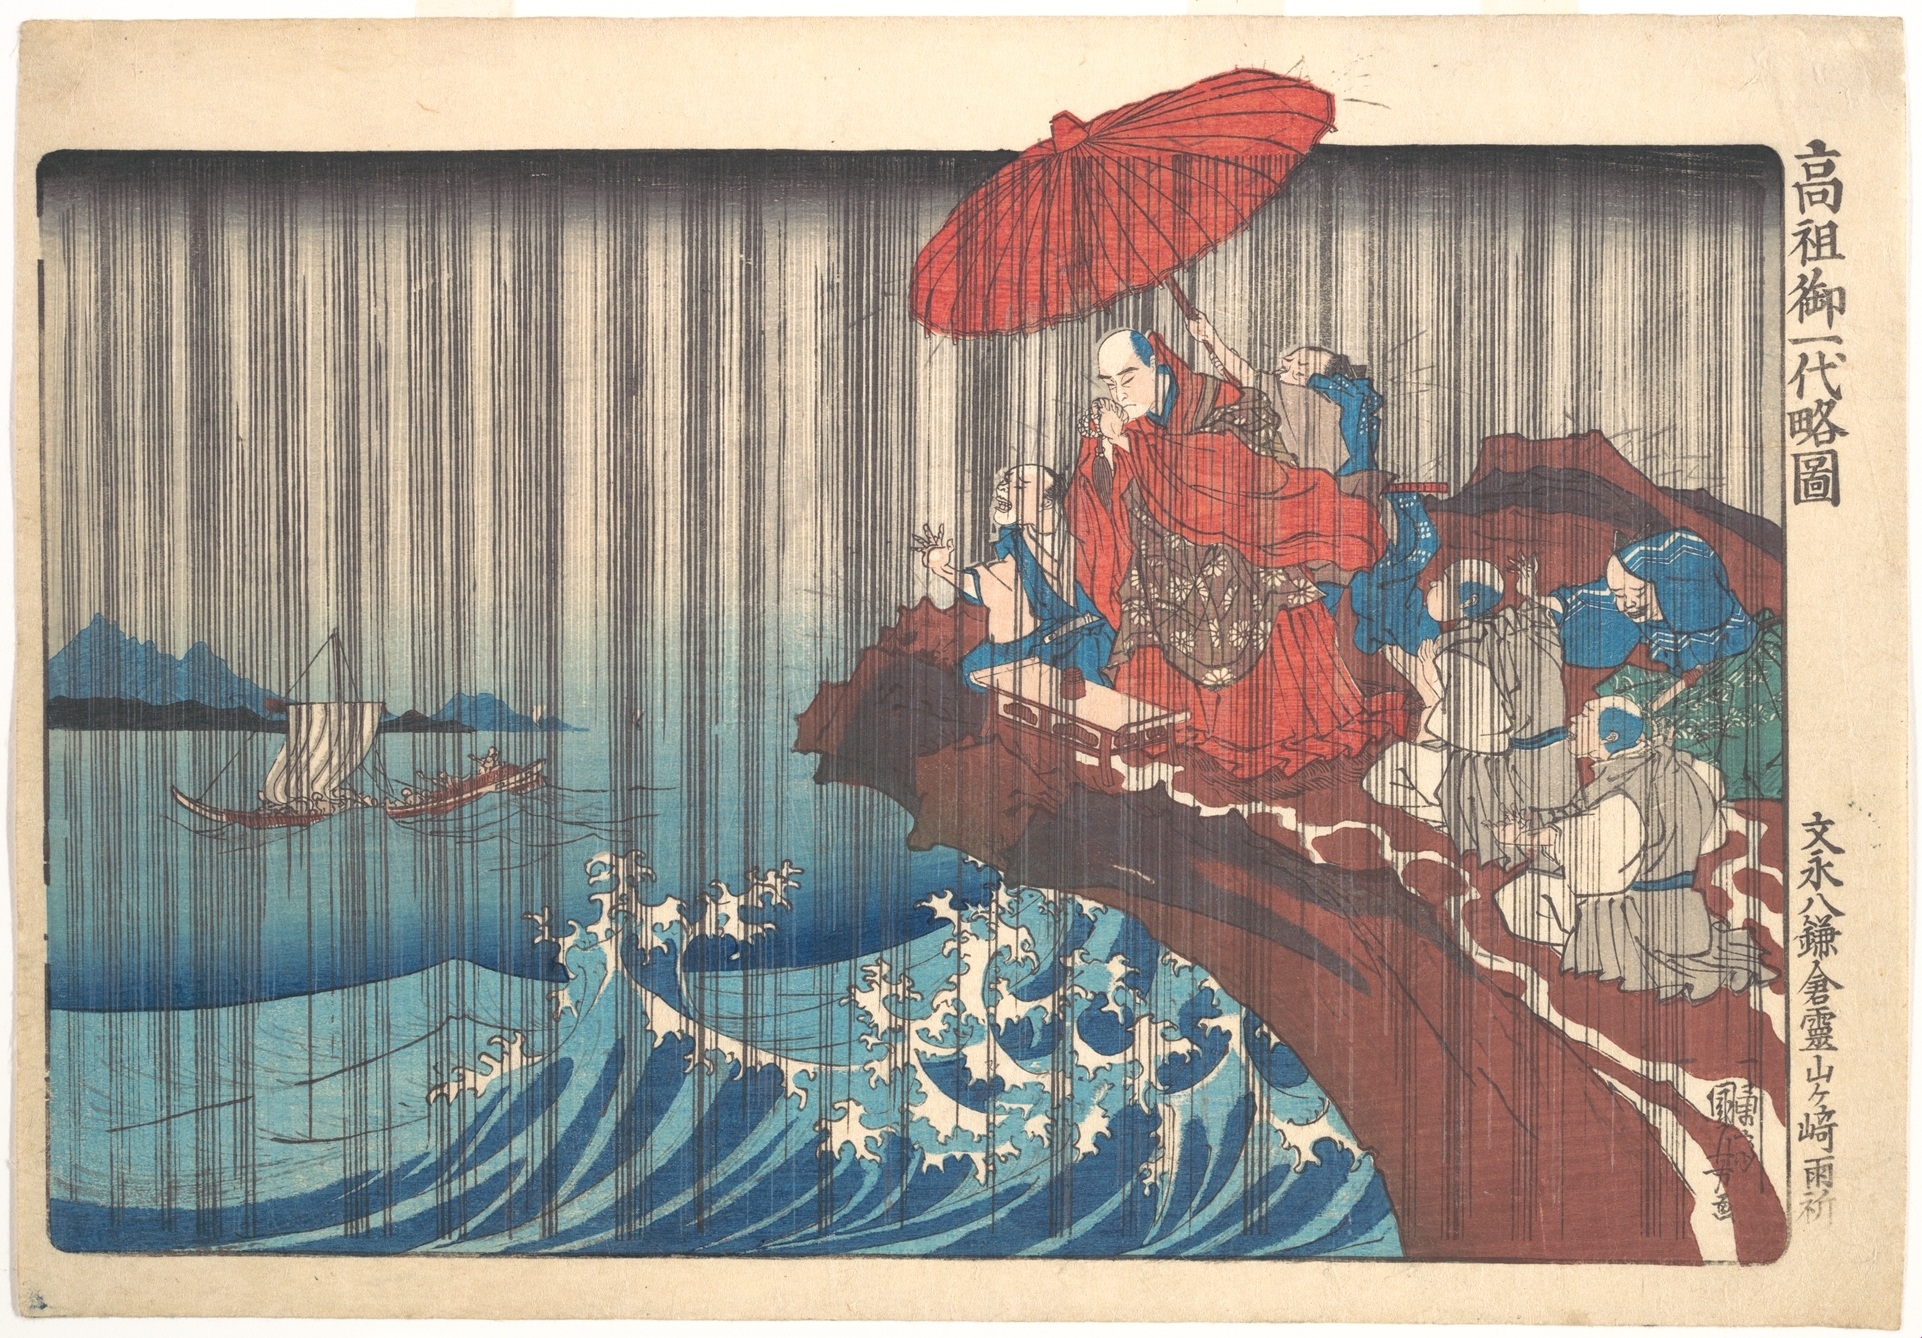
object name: print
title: Concise Illustrated Biography of Monk Nichiren: Prayer for Rain Answered at Ryōzengasaki in Kamakura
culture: japanese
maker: utagawa kuniyoshi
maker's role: artist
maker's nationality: japanese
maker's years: 1797-1861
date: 1835-1836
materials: ink, paper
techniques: woodblock print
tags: men,waves,rain,boats,umbrellas